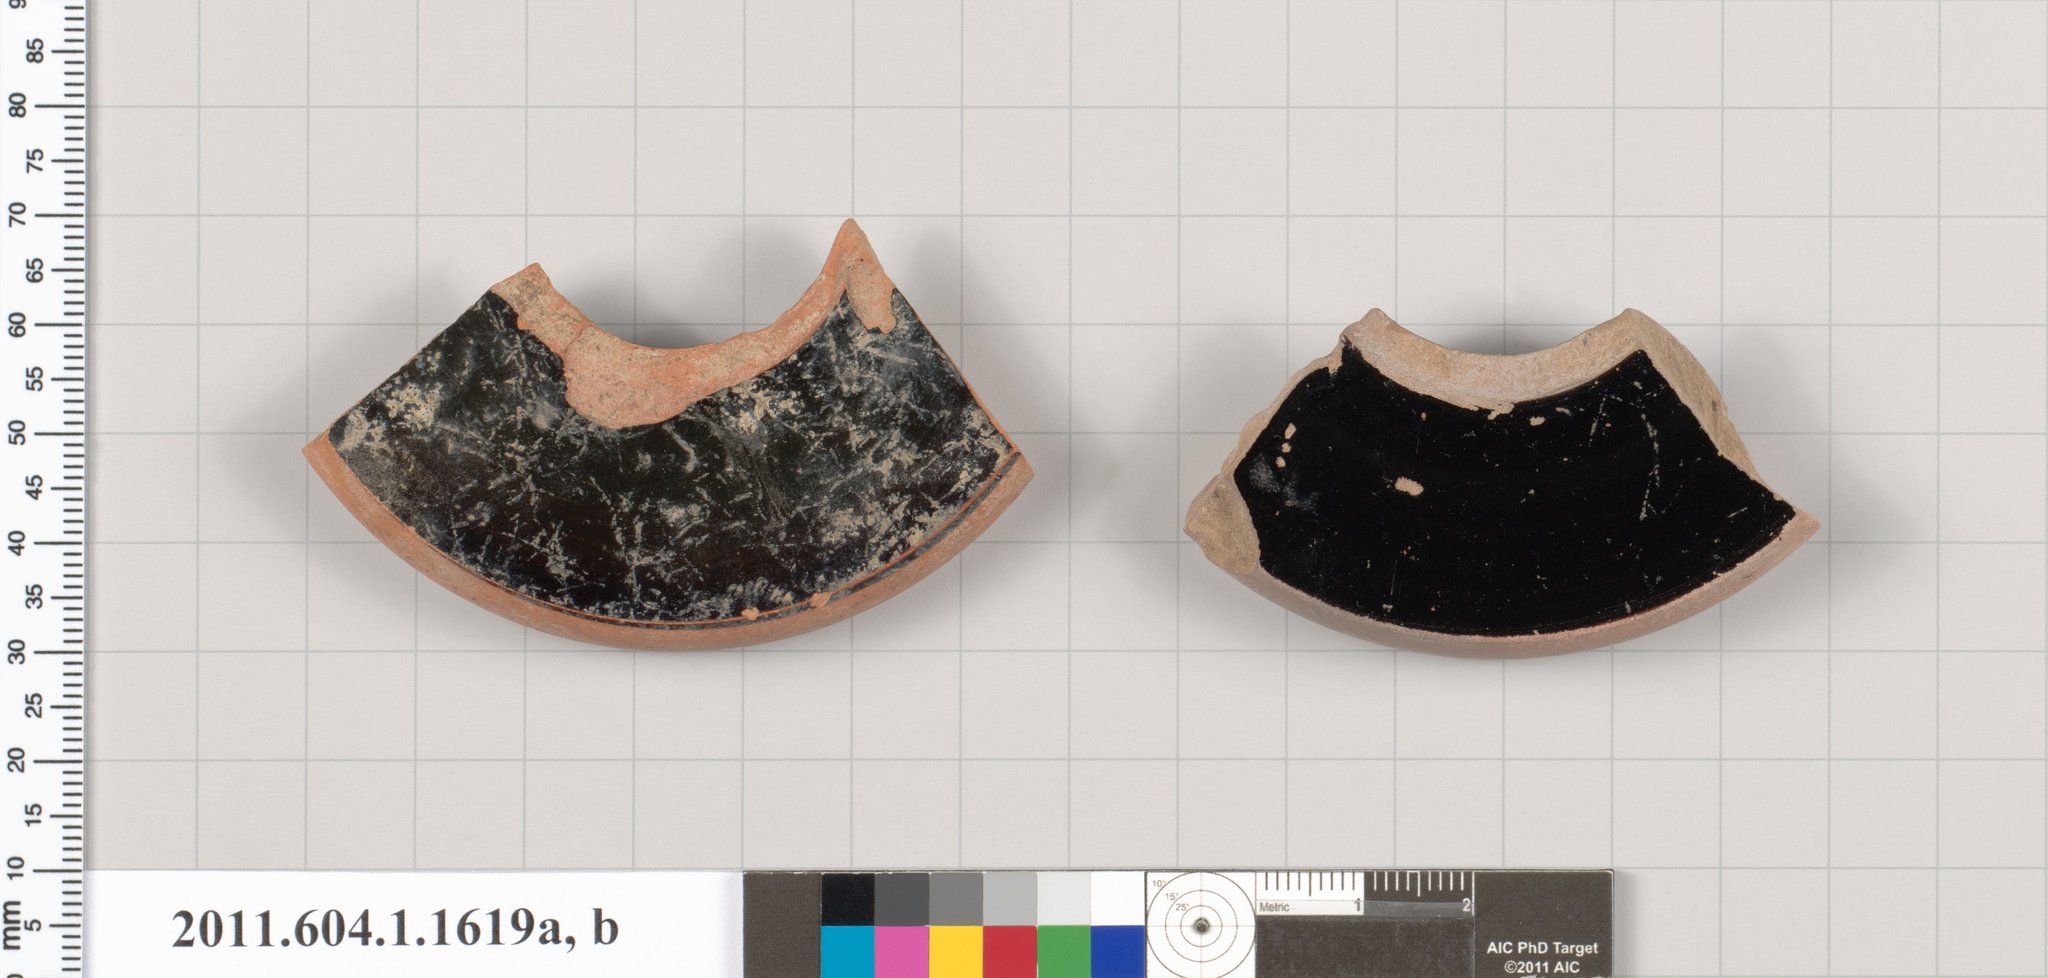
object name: kylix fragment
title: Terracotta fragments of kylikes (drinking cups)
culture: greek, attic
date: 500-401 BCE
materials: terracotta